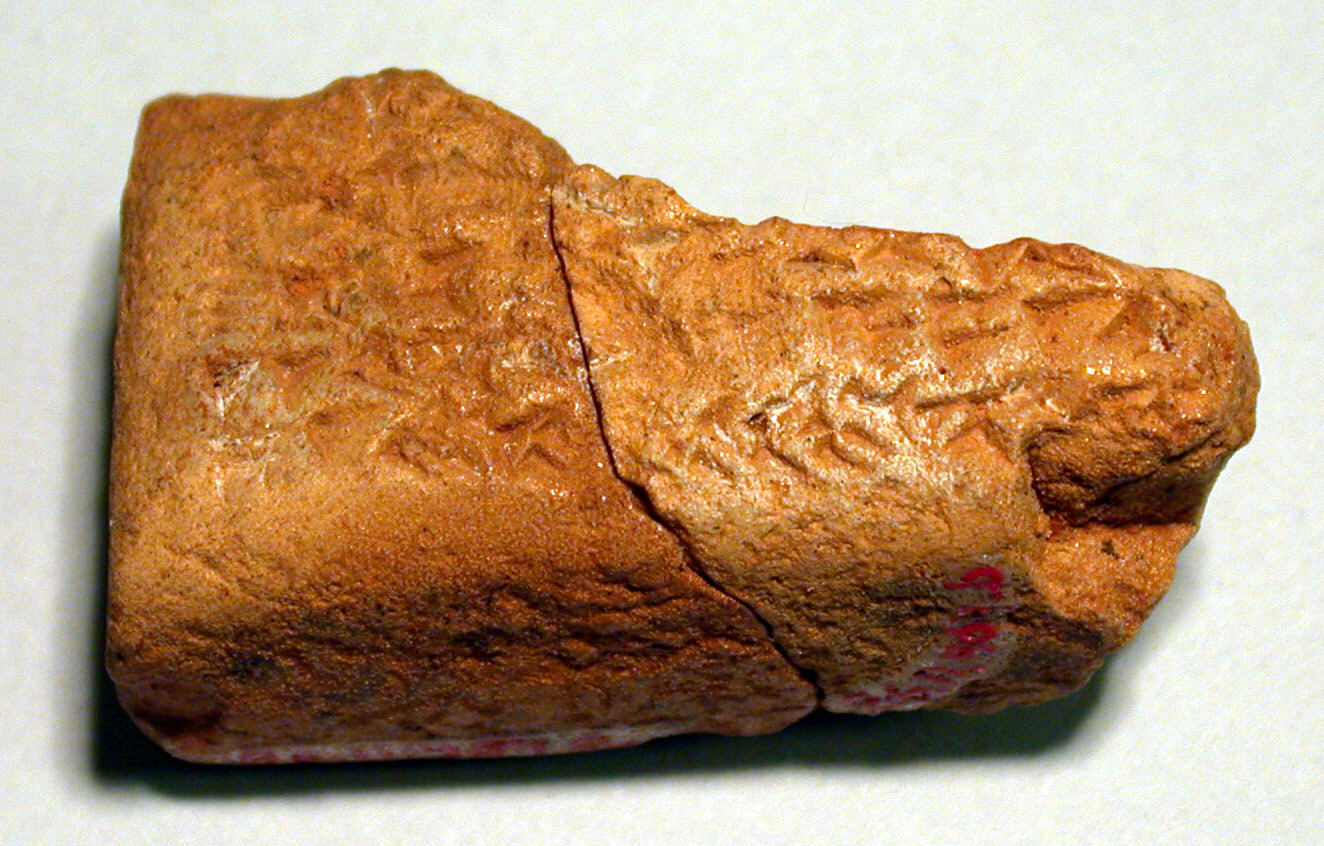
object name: cuneiform tablet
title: Cuneiform tablet: fragment of an agreement concerning a dowry (?)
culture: achaemenid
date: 434-401 BCE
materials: clay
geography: mesopotamia